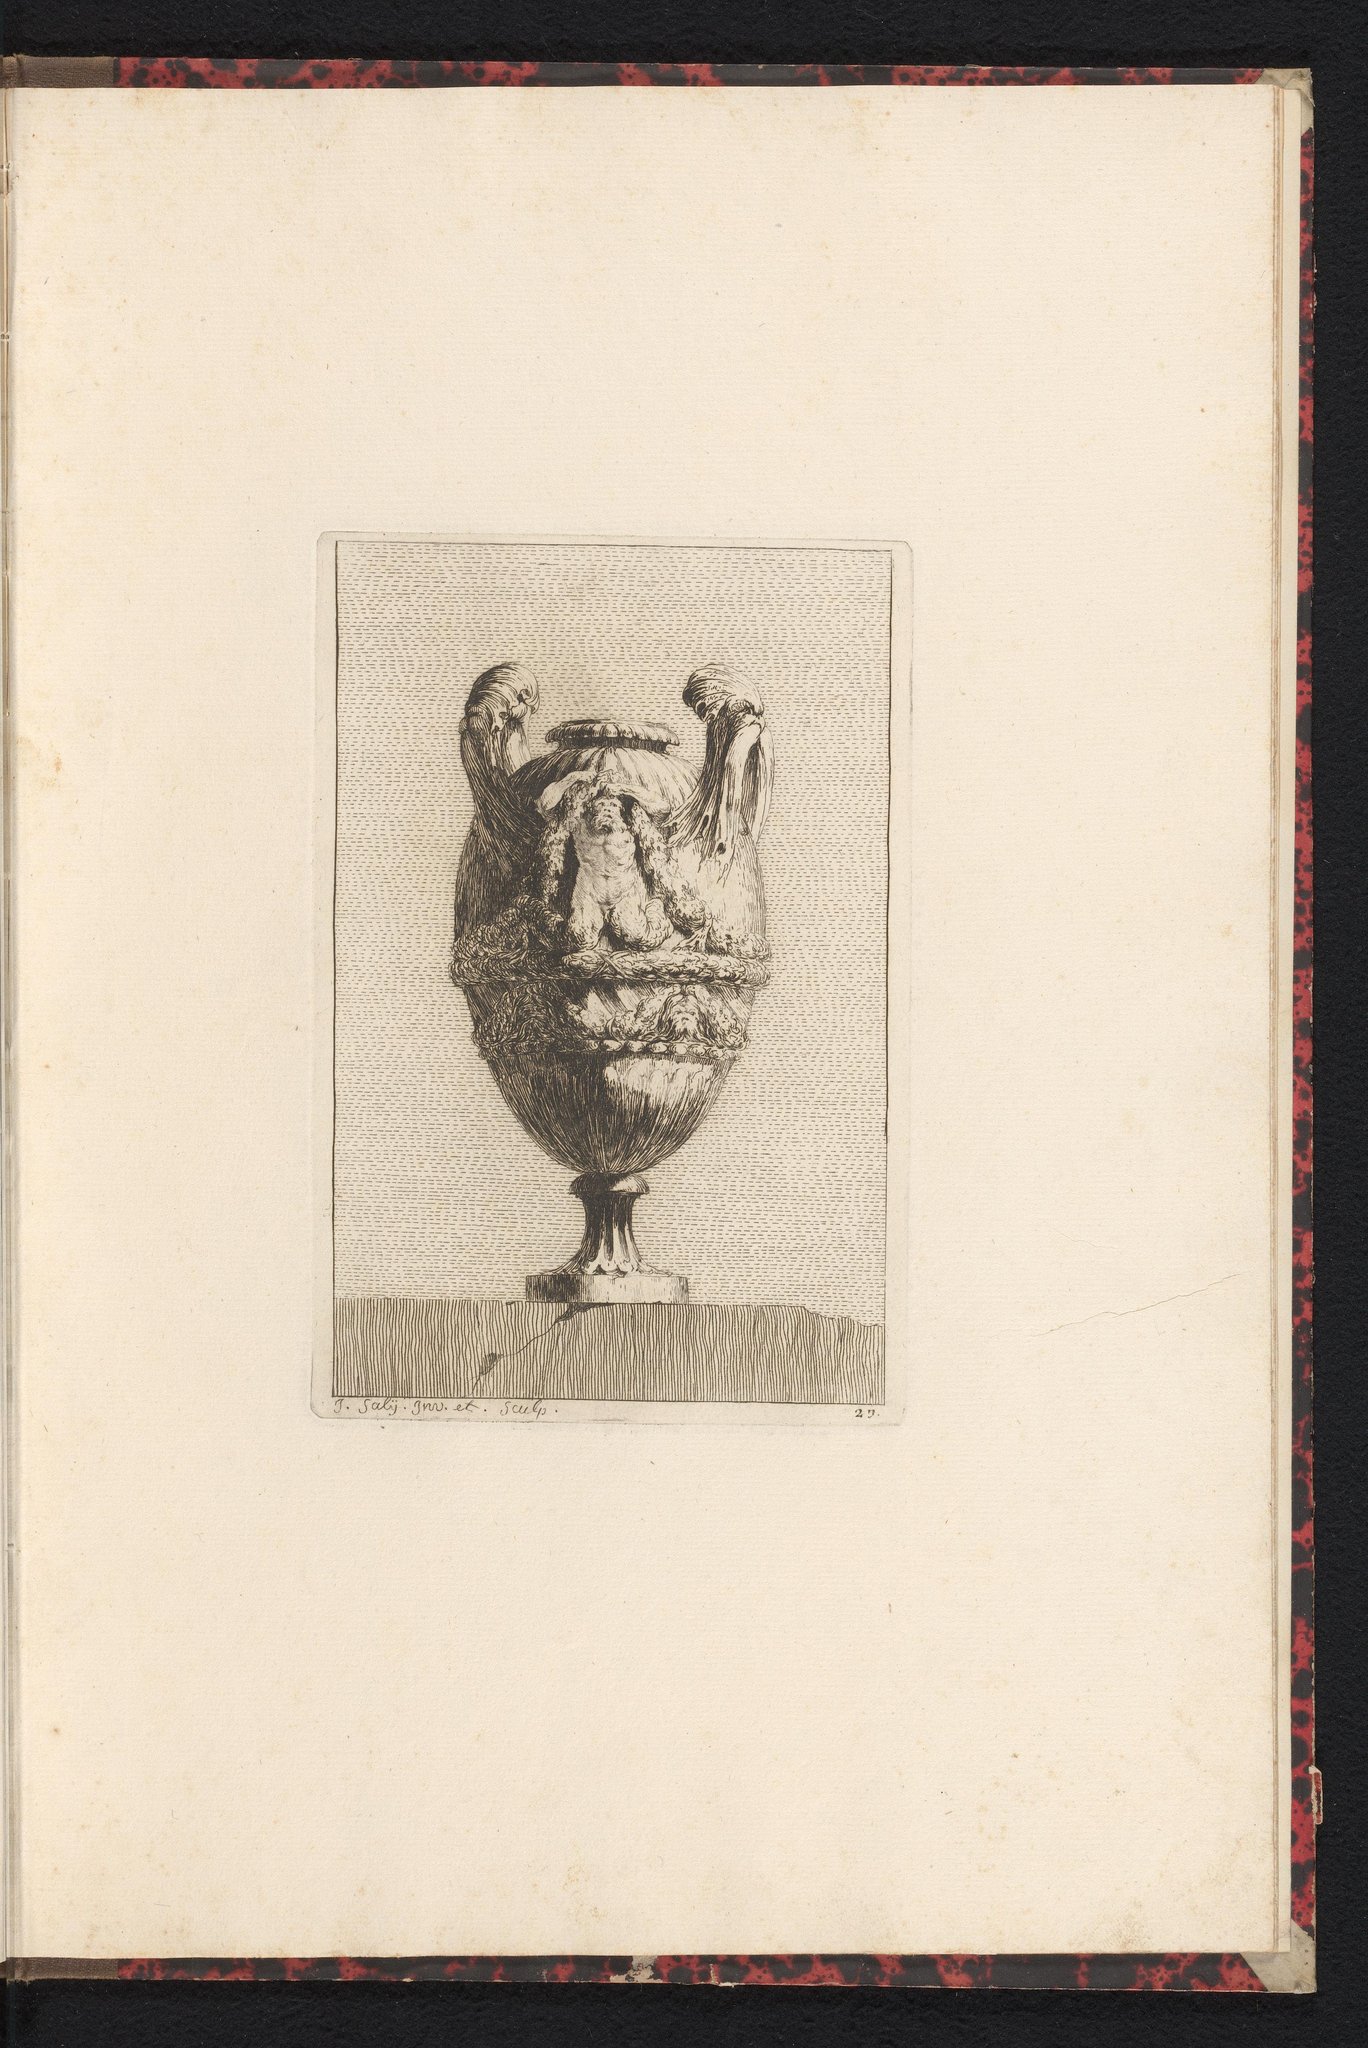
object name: album leaf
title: Vasa a se inventa atq. studii causa delin. et incisa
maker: jacques francois joseph saly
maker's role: print maker, sculptor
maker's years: 1717-1776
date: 1746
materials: paper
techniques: etching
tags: merman, mask, mascaron ~ ornament, ornament ~ festoon, garland, garden vase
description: Deze prent maakt deel uit van een album.